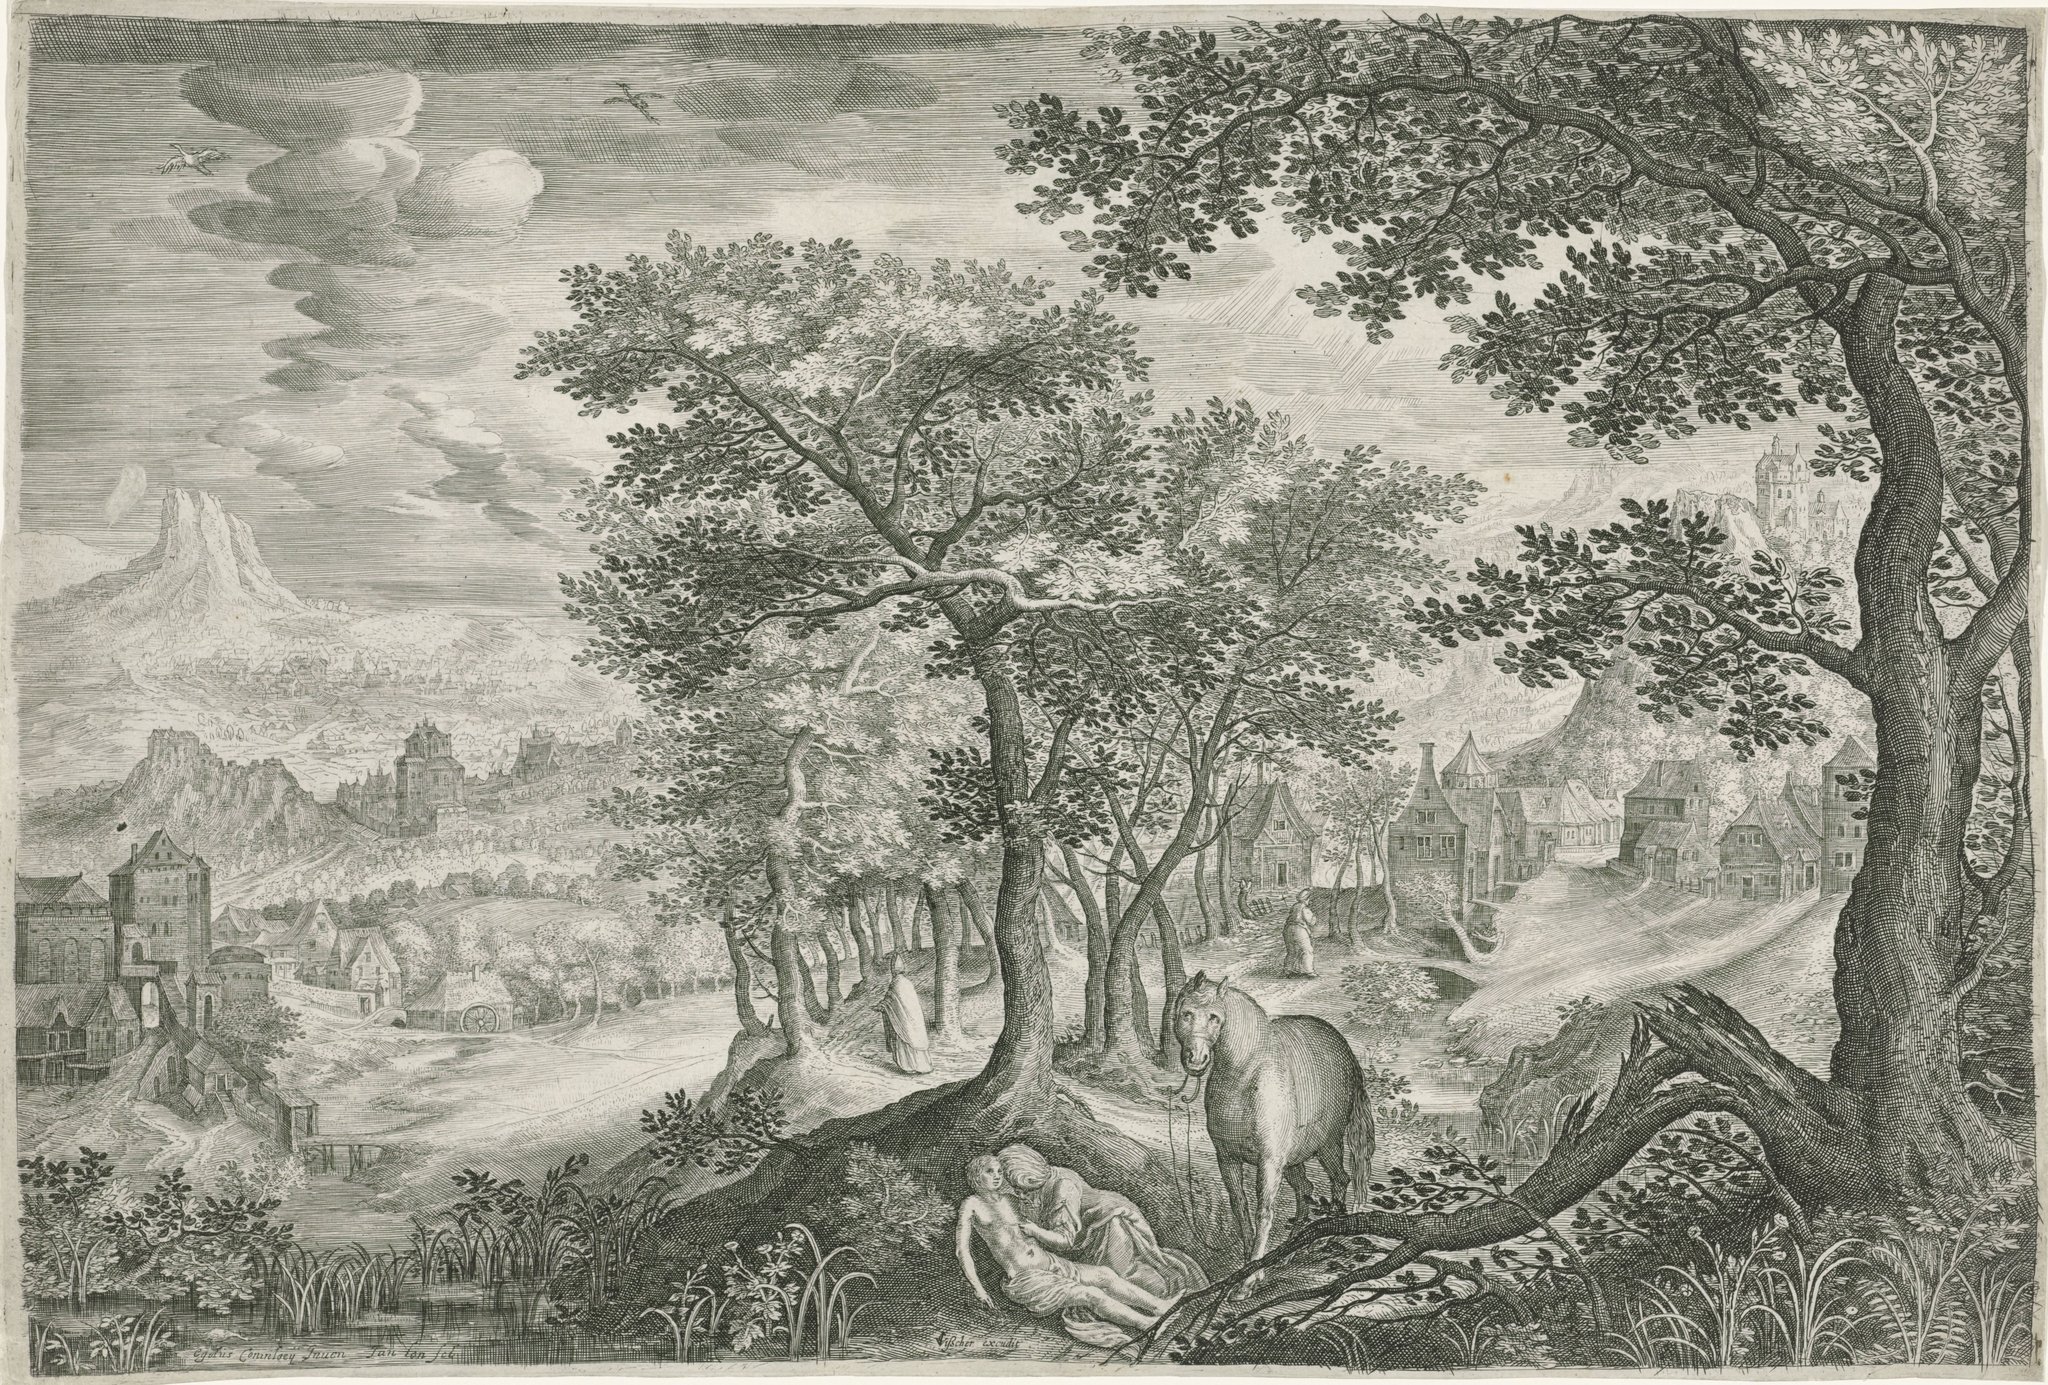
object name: print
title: Berglandschap met de barmhartige Samaritaan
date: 1601-1652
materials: paper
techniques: engraving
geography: amsterdam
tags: the good samaritan (luke 10:30-37), mountains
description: Berglandschap met verspreid groepjes huizen. Op de voorgrond tilt de barmhartige Samaritaan de gewonde reiziger van de grond om hem op zijn paard te zetten. Tussen de bomen lopen de Leviet en de priester, figuren die de reiziger aan zijn lot overlieten.